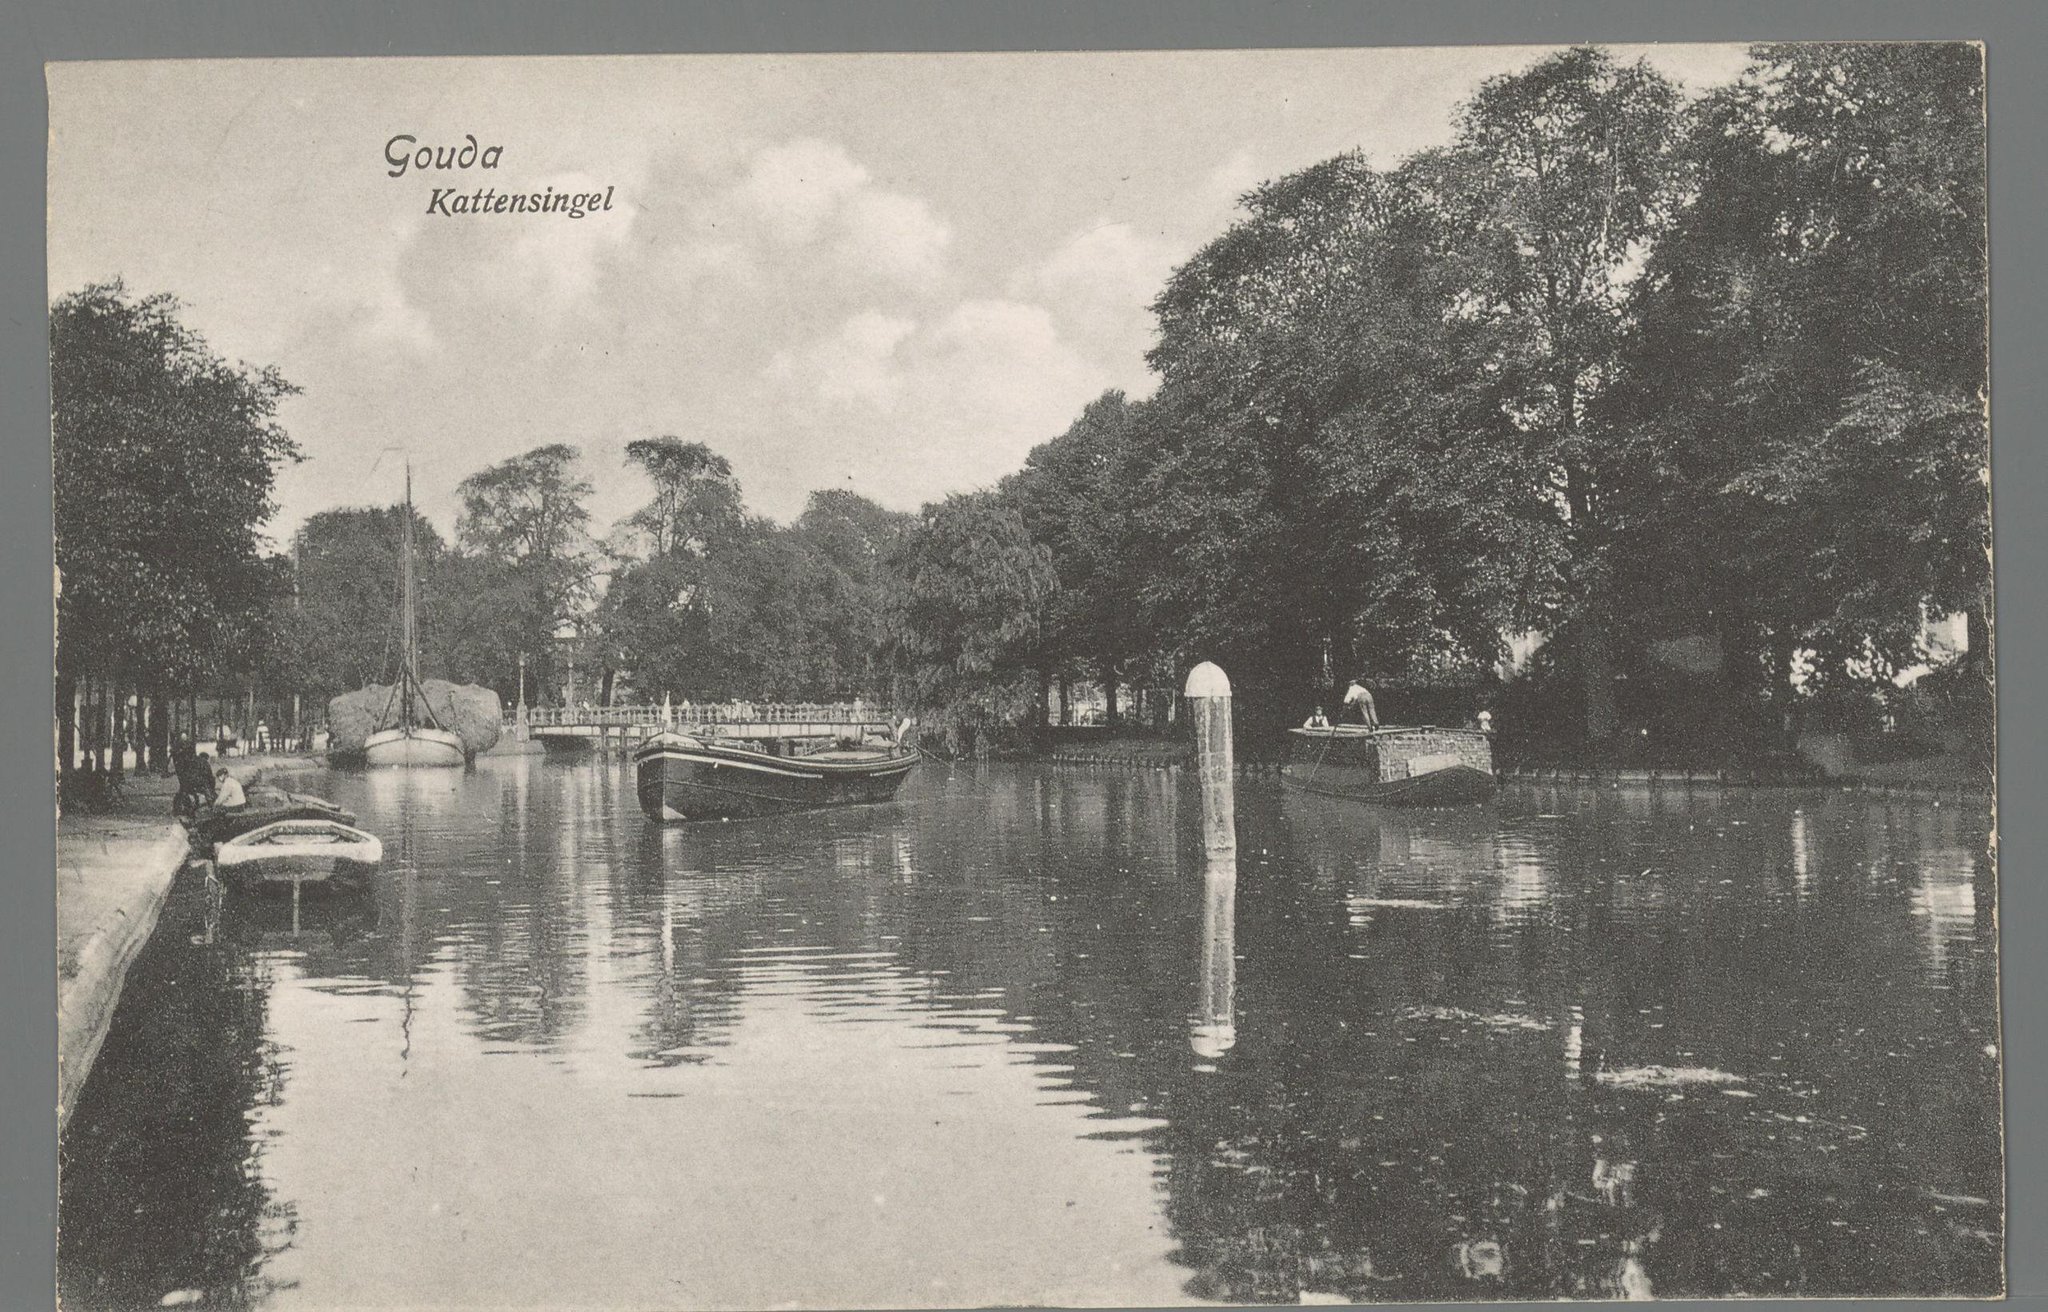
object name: ansichtkaart, prentbriefkaart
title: Gouda. Kattensingel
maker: Anonymous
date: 1908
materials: cardboard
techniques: photograph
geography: gouda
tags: canal, ships (in general), gouda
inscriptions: date